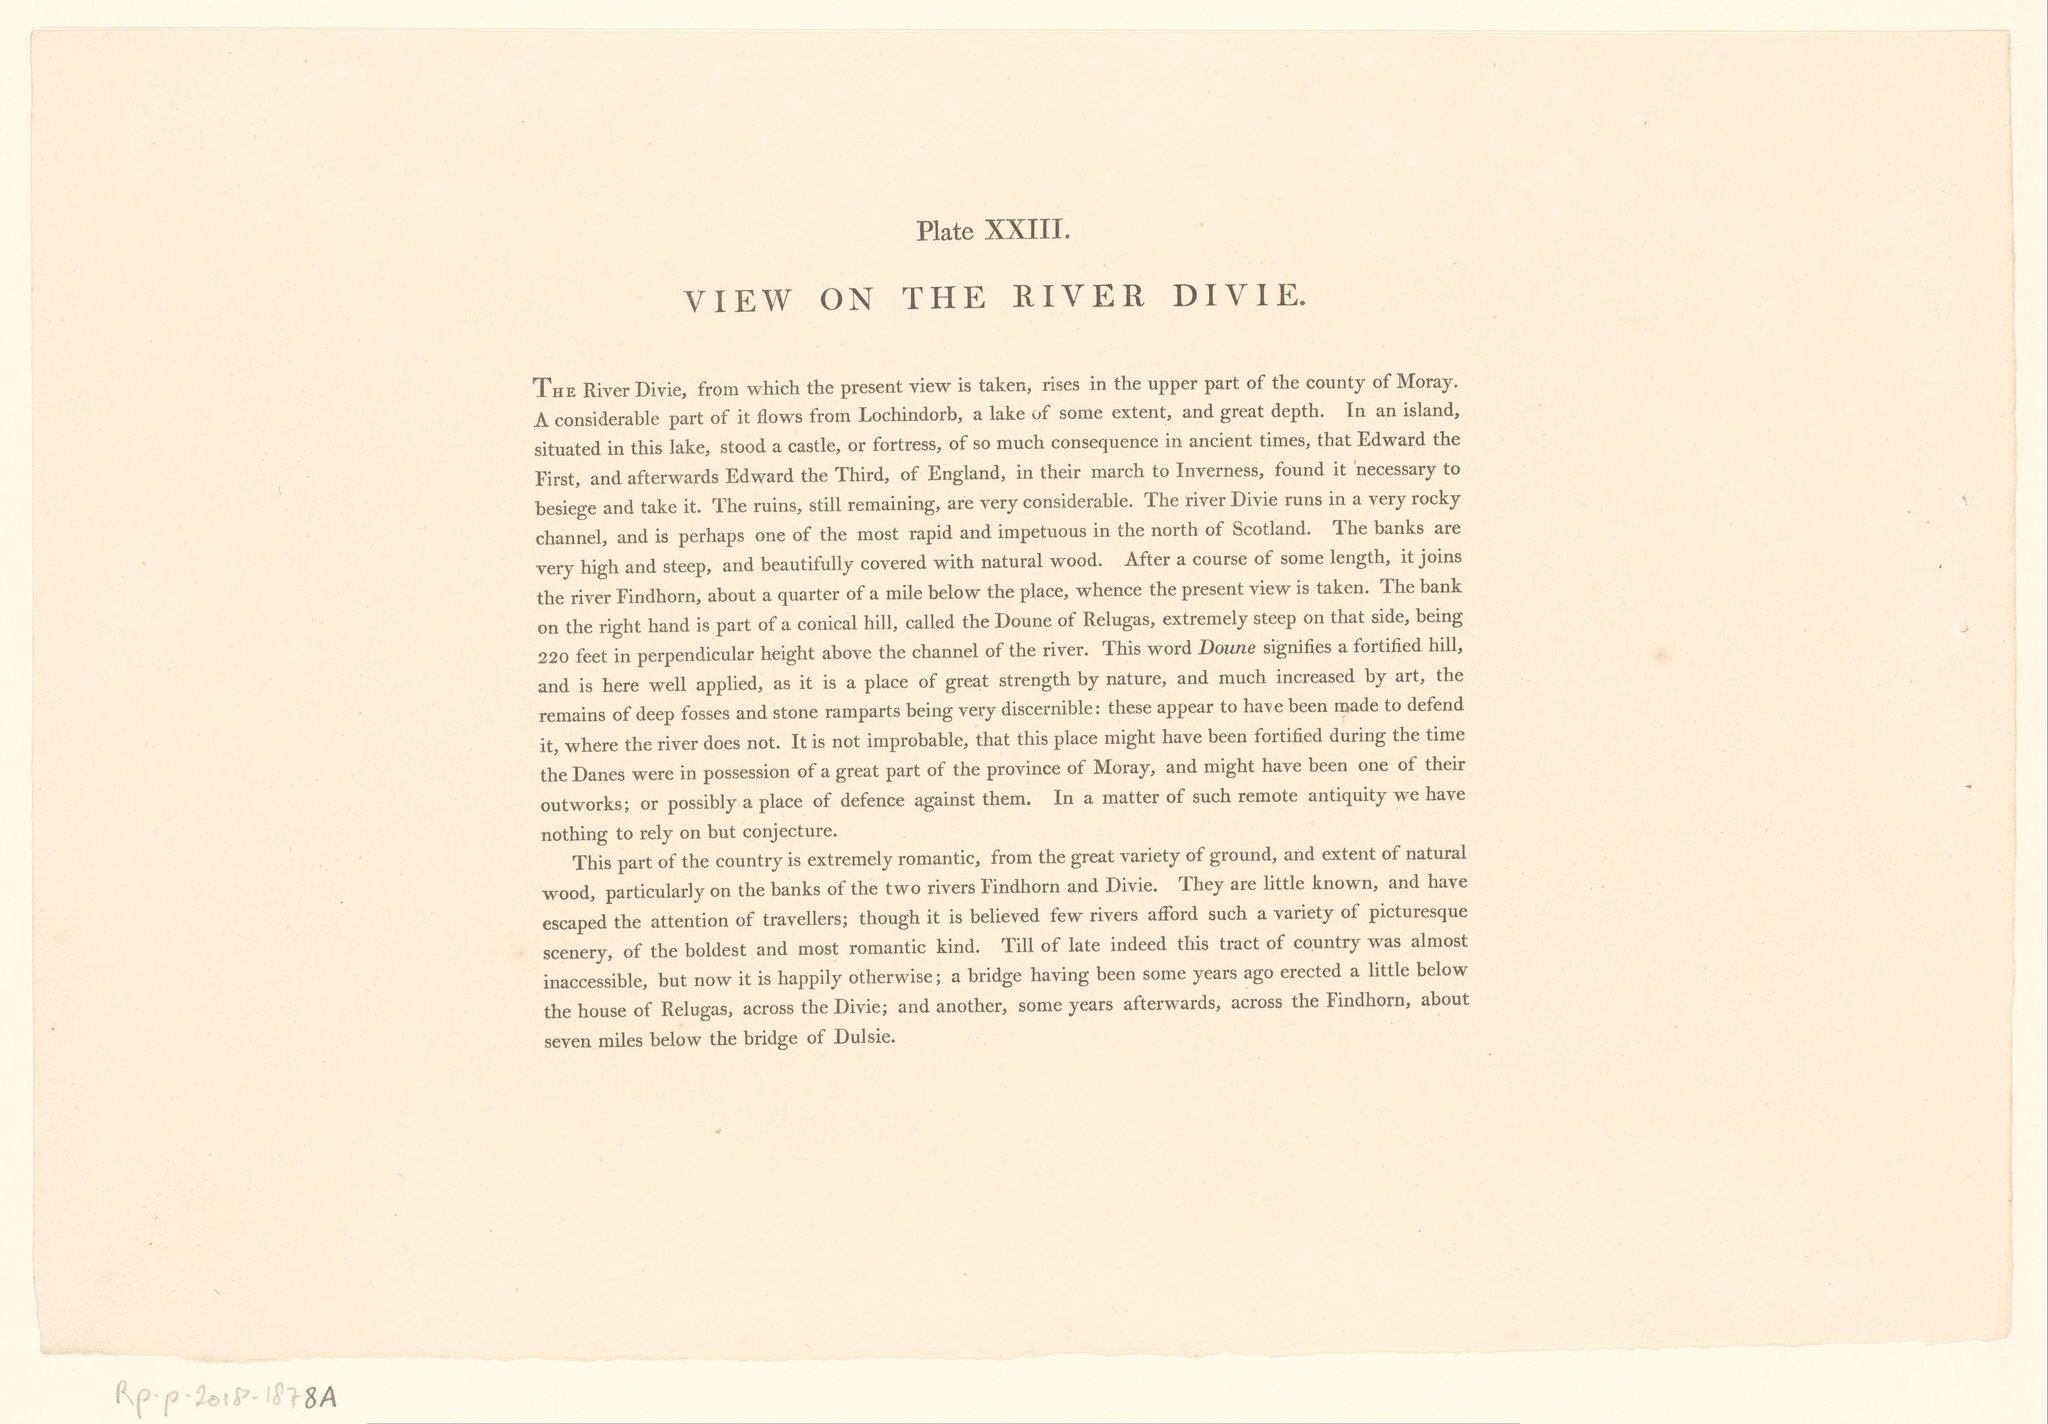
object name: text sheet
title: Plate XXIII. View on the river Divie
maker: william miller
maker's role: bookseller, printer, publisher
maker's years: 1769-1844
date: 1801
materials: paper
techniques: letterpress printing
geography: london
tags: schotland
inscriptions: collector's mark: Lugt 2228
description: Tekstblad gebruikt in: Scotia Depicta; or the antiquities, castles, public buildings, noblemen (...). Londen: William Miller, 1801.